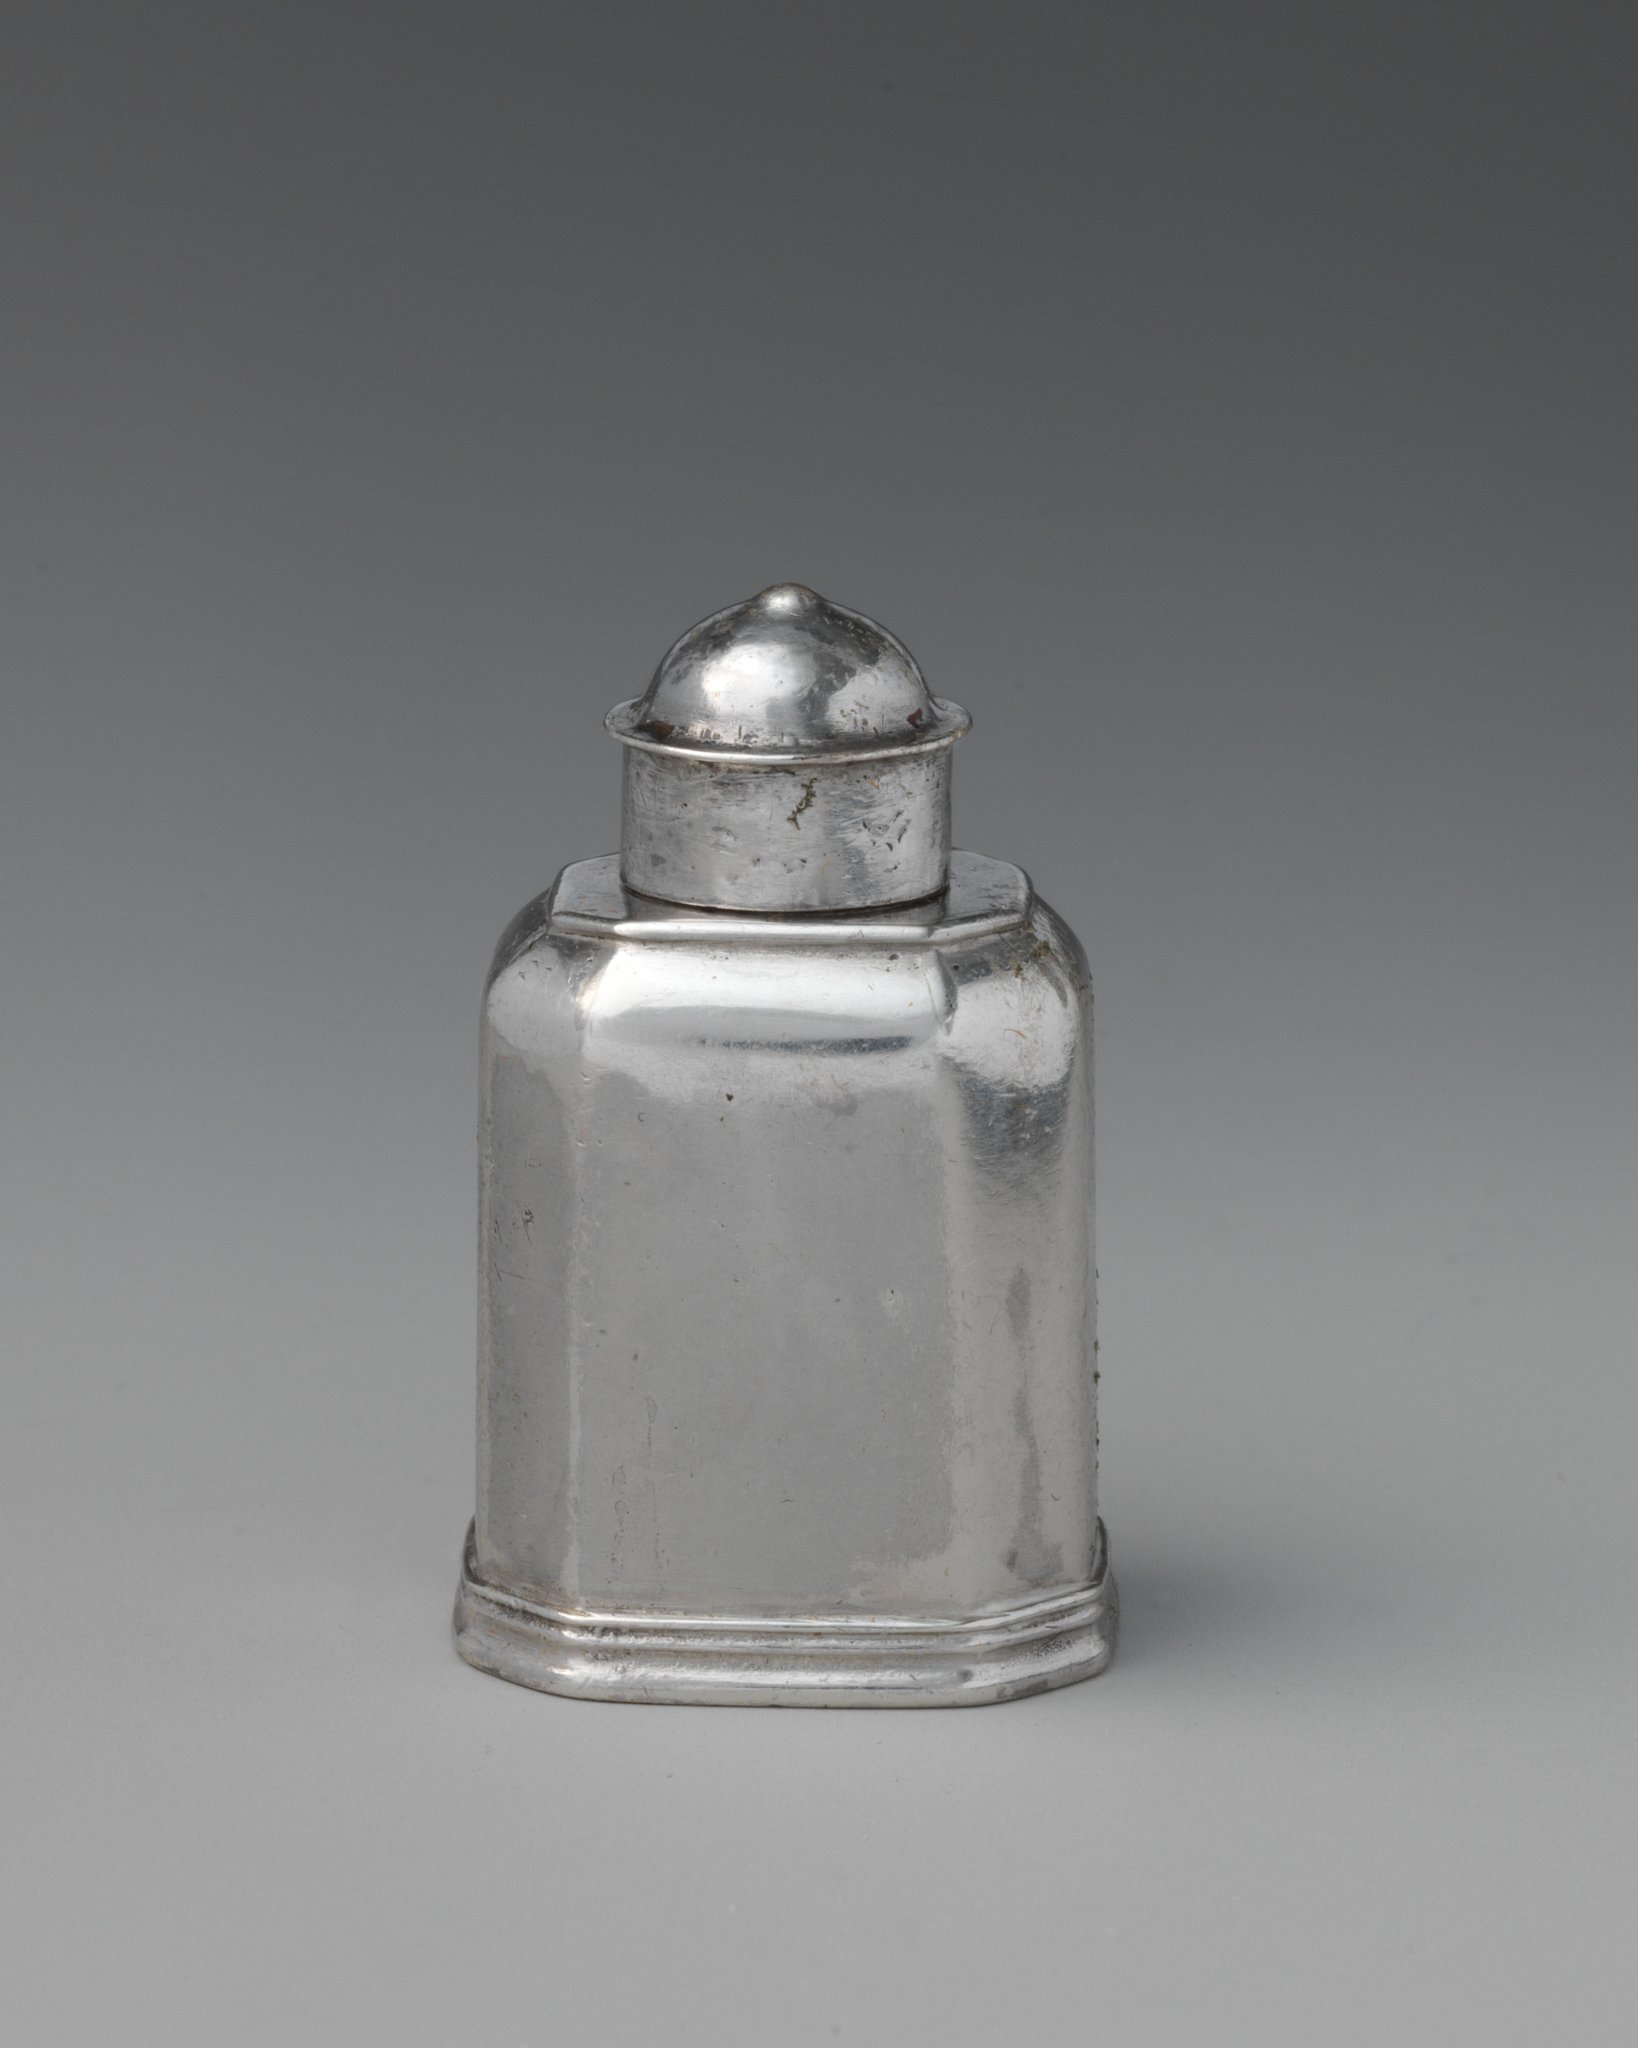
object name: tea caddy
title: Miniature tea caddy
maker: david clayton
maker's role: artist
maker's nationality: british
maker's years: 1659-1719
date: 1720-1730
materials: silver